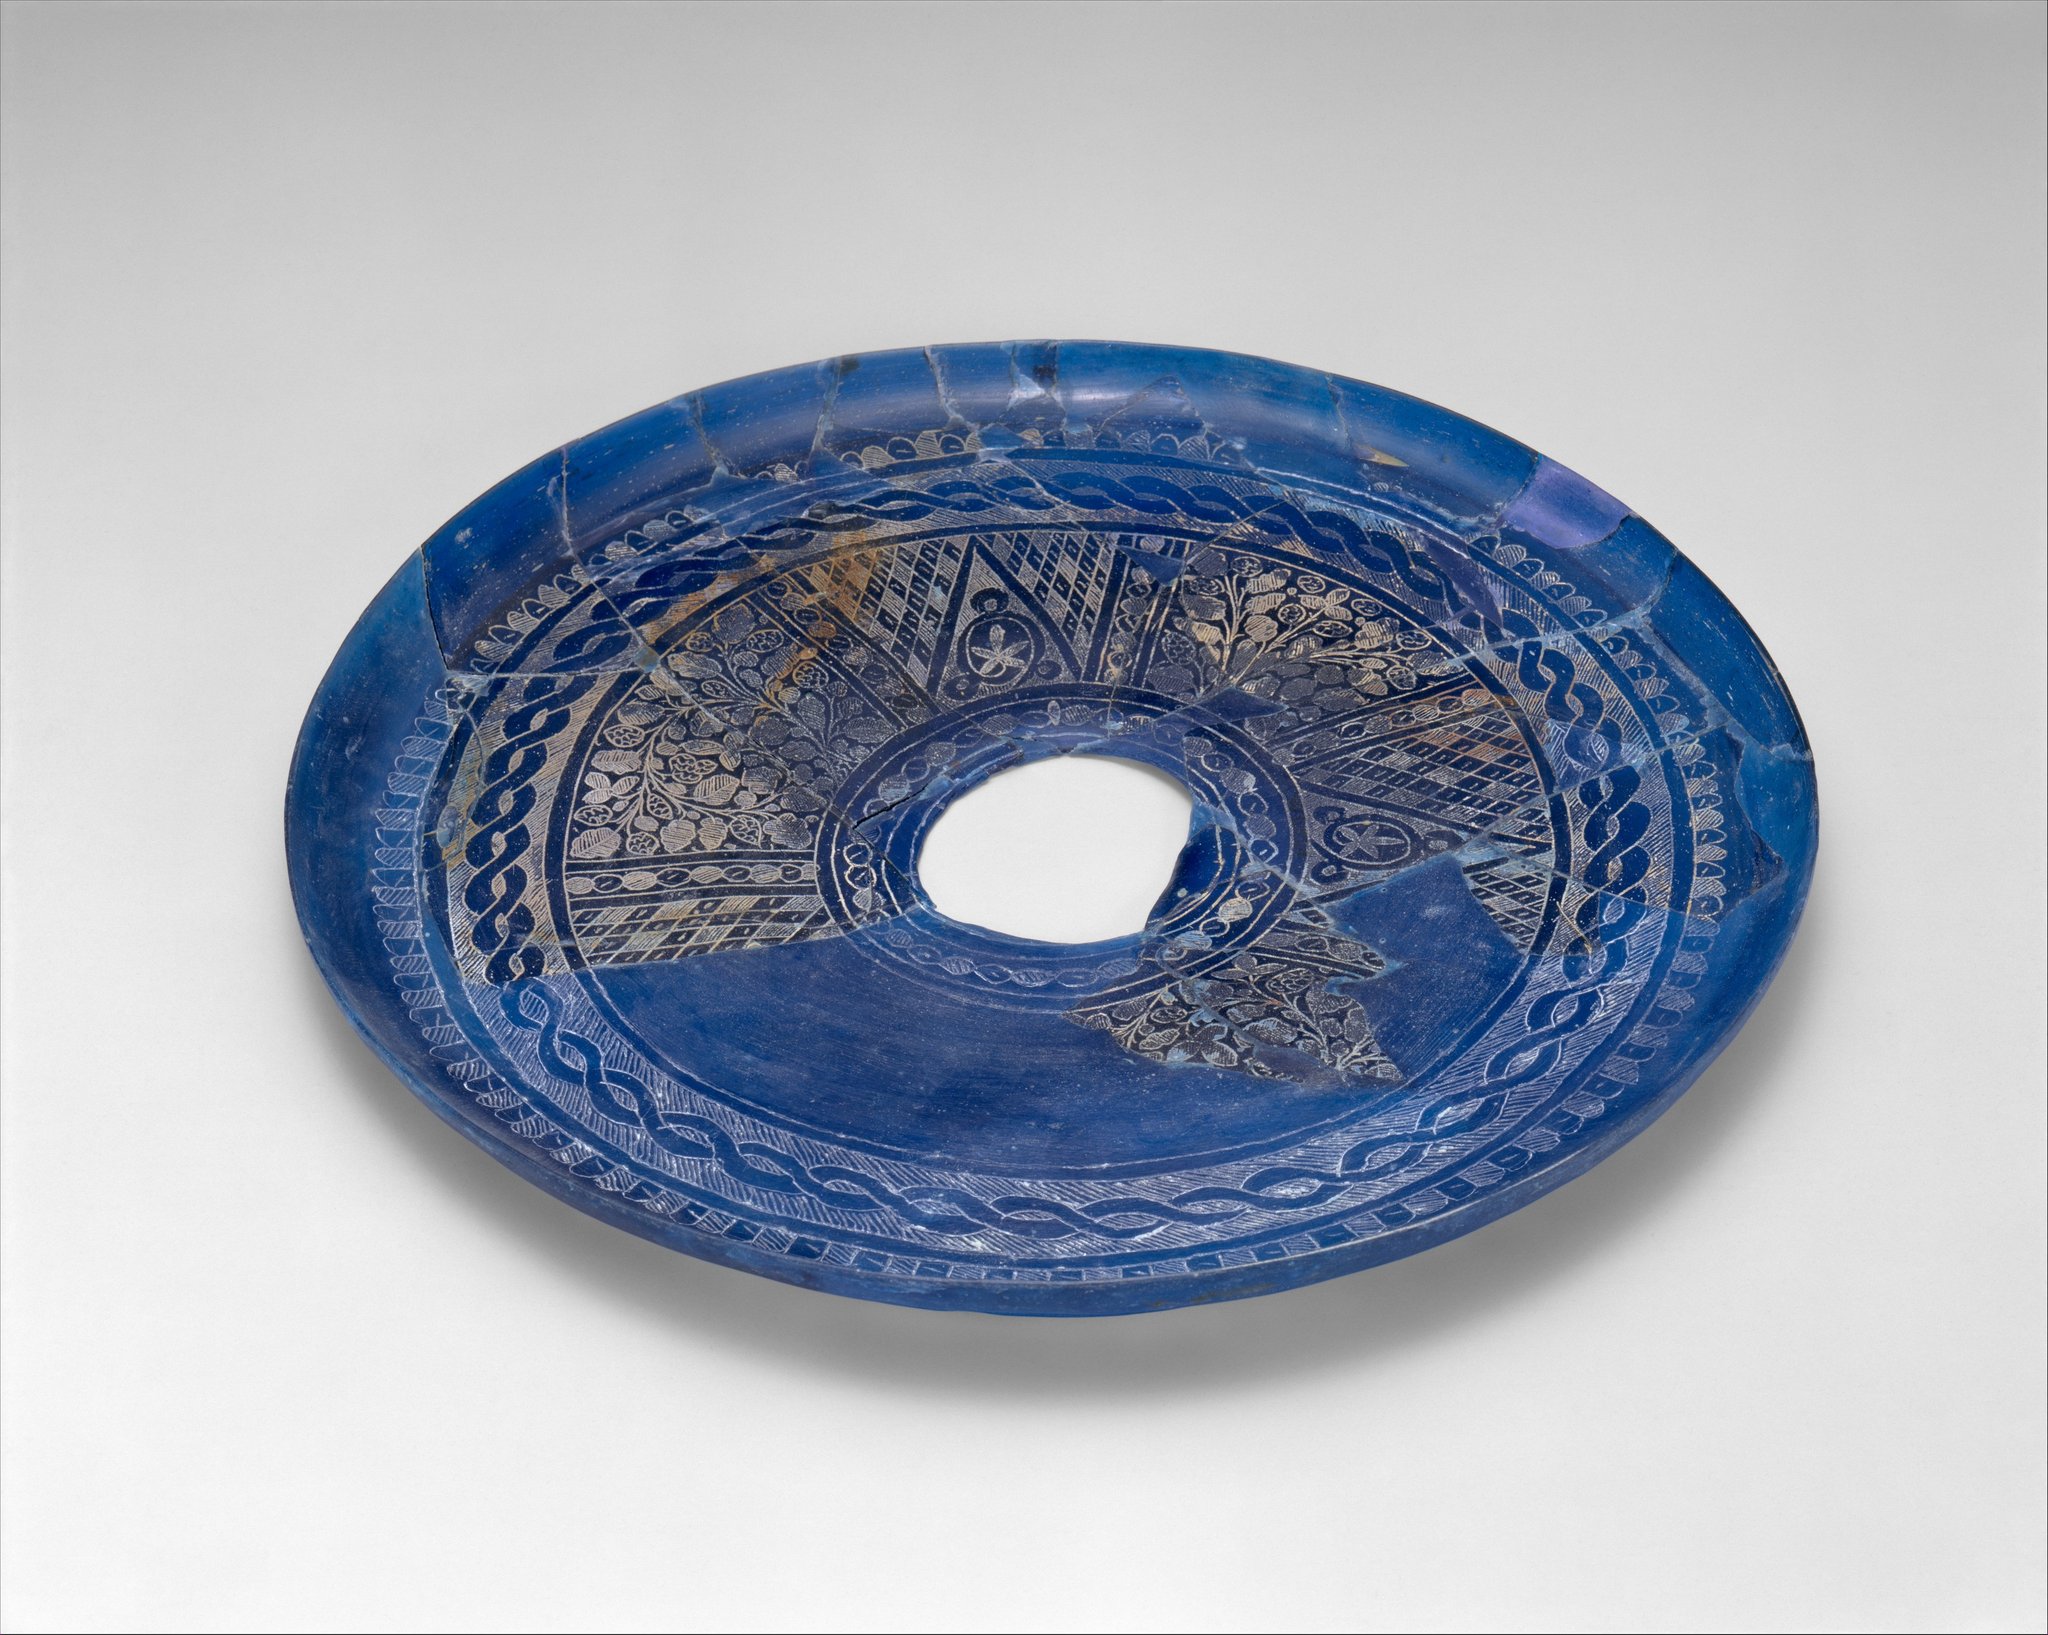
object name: fragmentary plate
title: Fragmentary Plate with Engraved Designs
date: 801-900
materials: glass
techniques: glassblowing, engraving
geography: syria